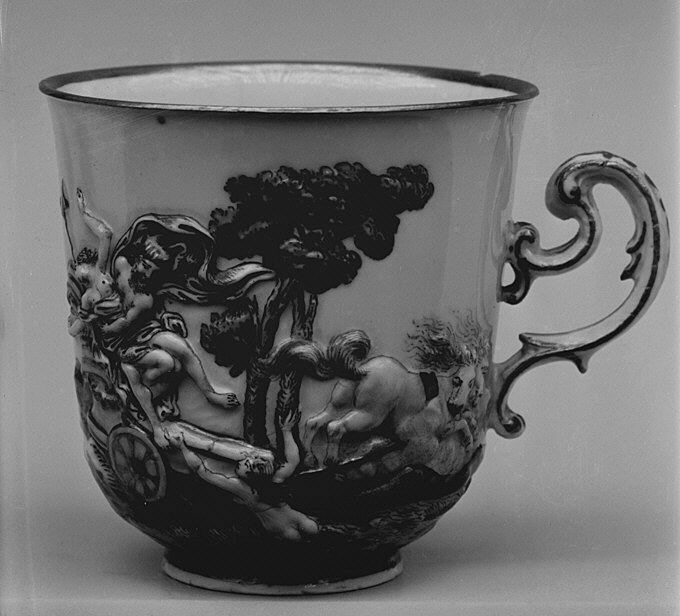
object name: coffee cup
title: Coffee cup (part of a service)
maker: doccia porcelain manufactory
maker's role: manufactory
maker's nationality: italian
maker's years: 1737-1896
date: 1760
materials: hard paste porcelain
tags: men,women,horses,trees